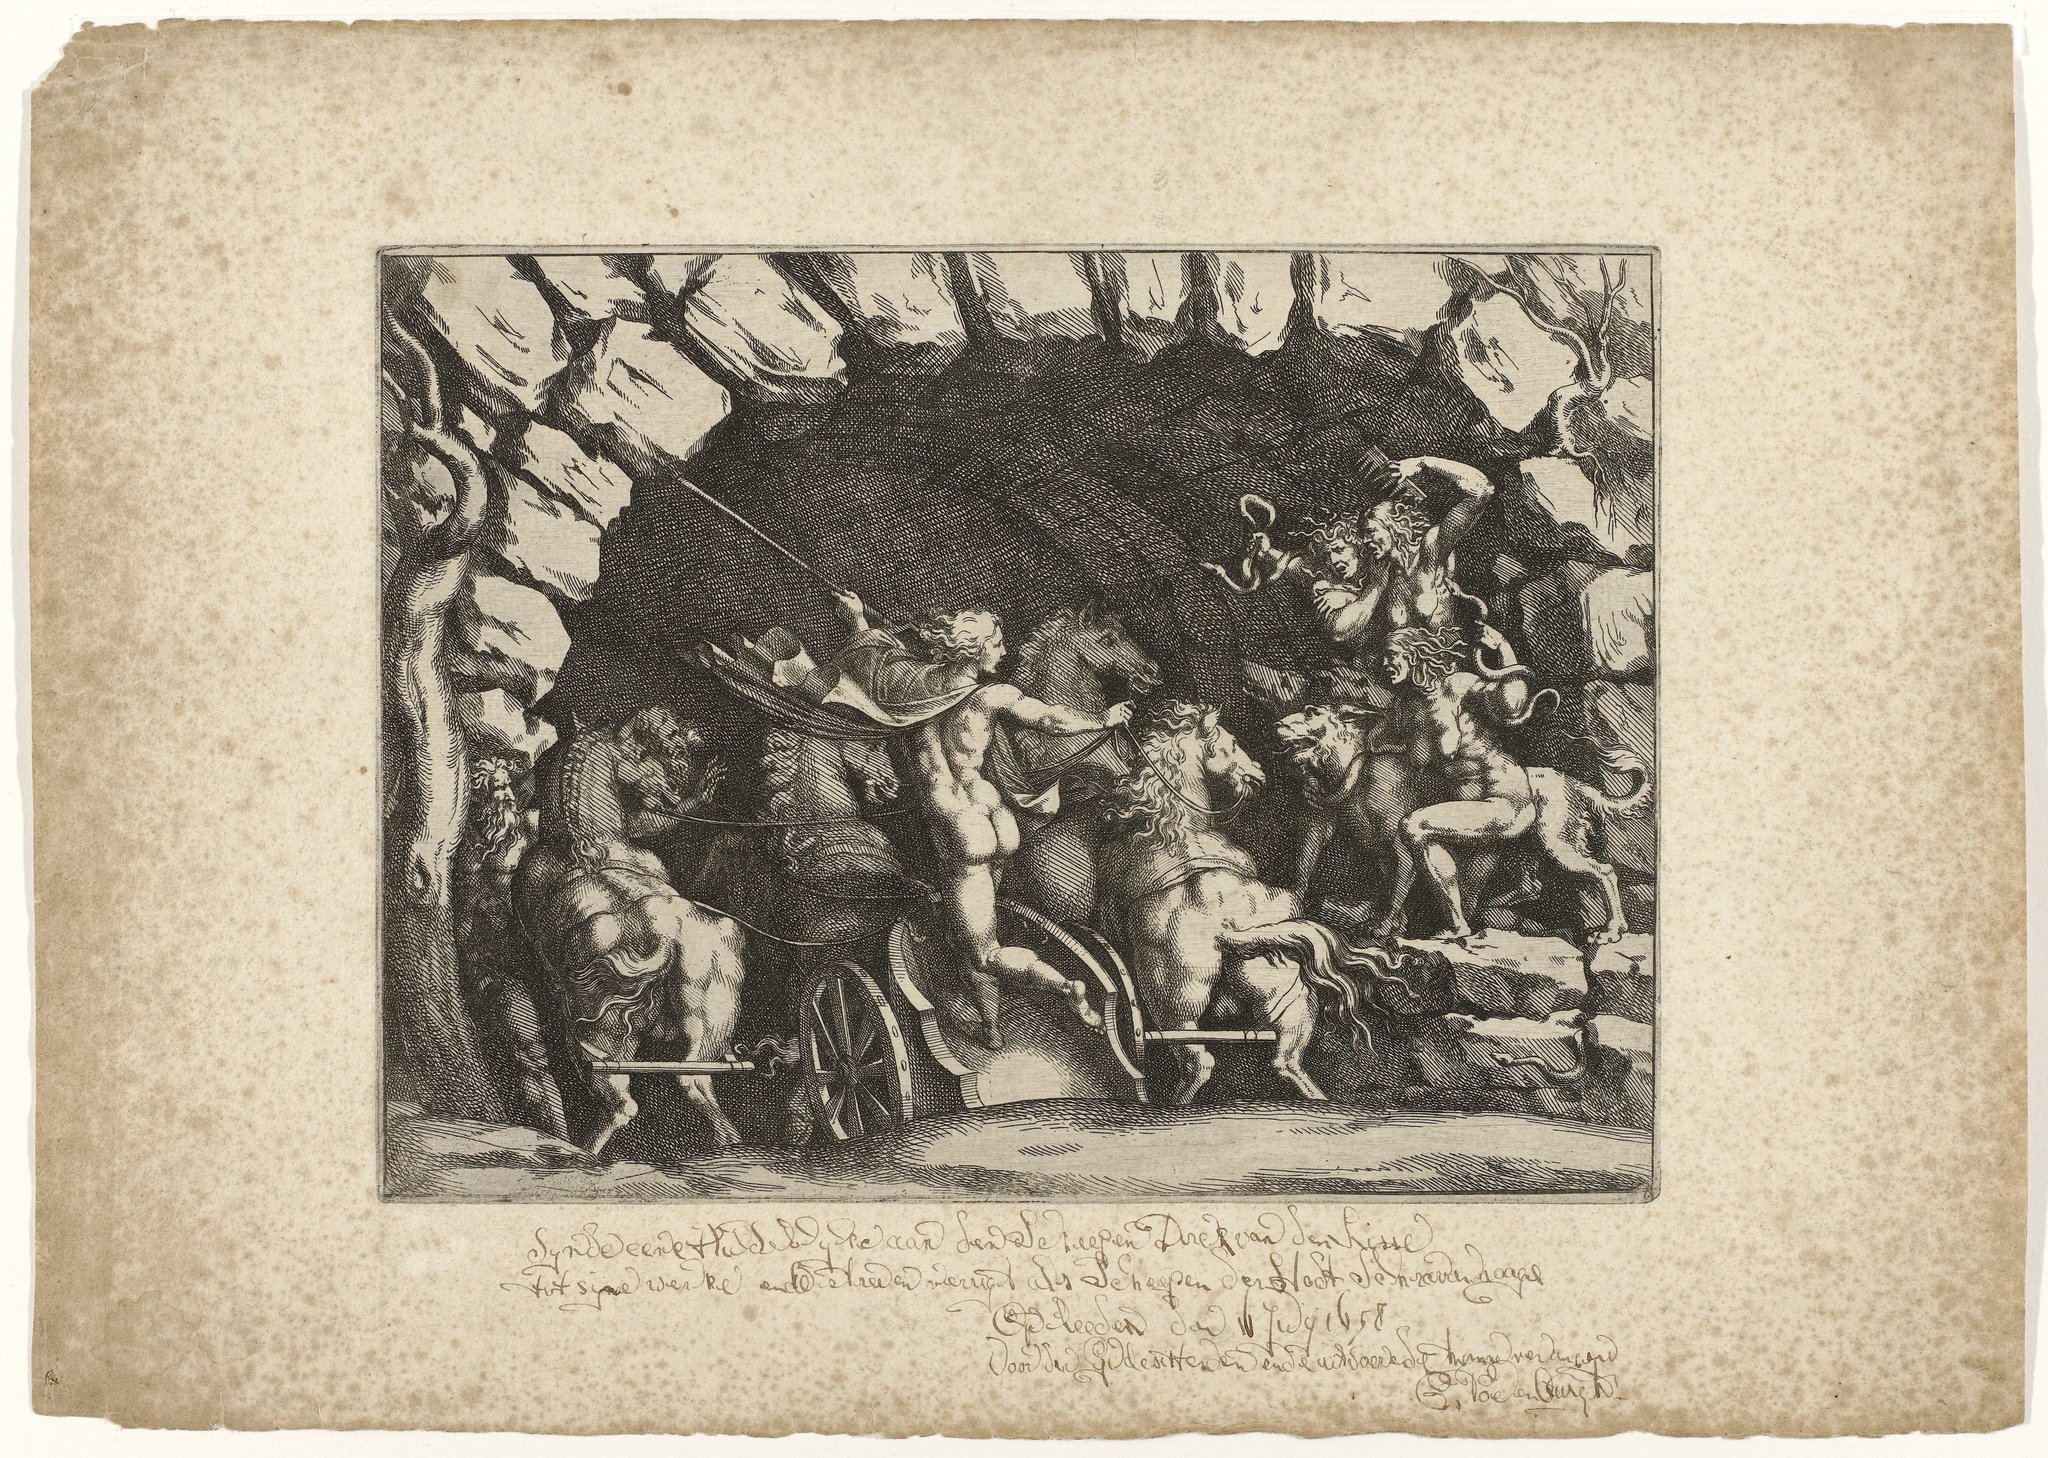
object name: print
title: Pluto gaat de onderwereld in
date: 1645-1658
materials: paper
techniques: etching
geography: mantua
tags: (story of) pluto (hades), dis pater, orcus, furies, dirae (erinyes), eumenides; 'furie' (ripa), cerberus, the three- or many-headed dog; 'cerbero' (ripa)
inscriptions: inscription: ‘Synde eenen huldeblijke aan den Scheepen Direk van den Lisse. / Tot zijne werken ende streven verrigt als scheepen der stadt Schraevenhaage. / Op heeden den 16 July 1658 / voor den Gilde sittende ende uitvoerende....(kunnen vercopen?). / C. Poelenburgh.’, collector's mark: Lugt 2228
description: Pluto rijdt de onderwerld in op zijn strijdwagen die wordt getrokken door vier paarden. De ingang wordt bewaakt door de driekoppige hond Cerberus en de drie Furiën.